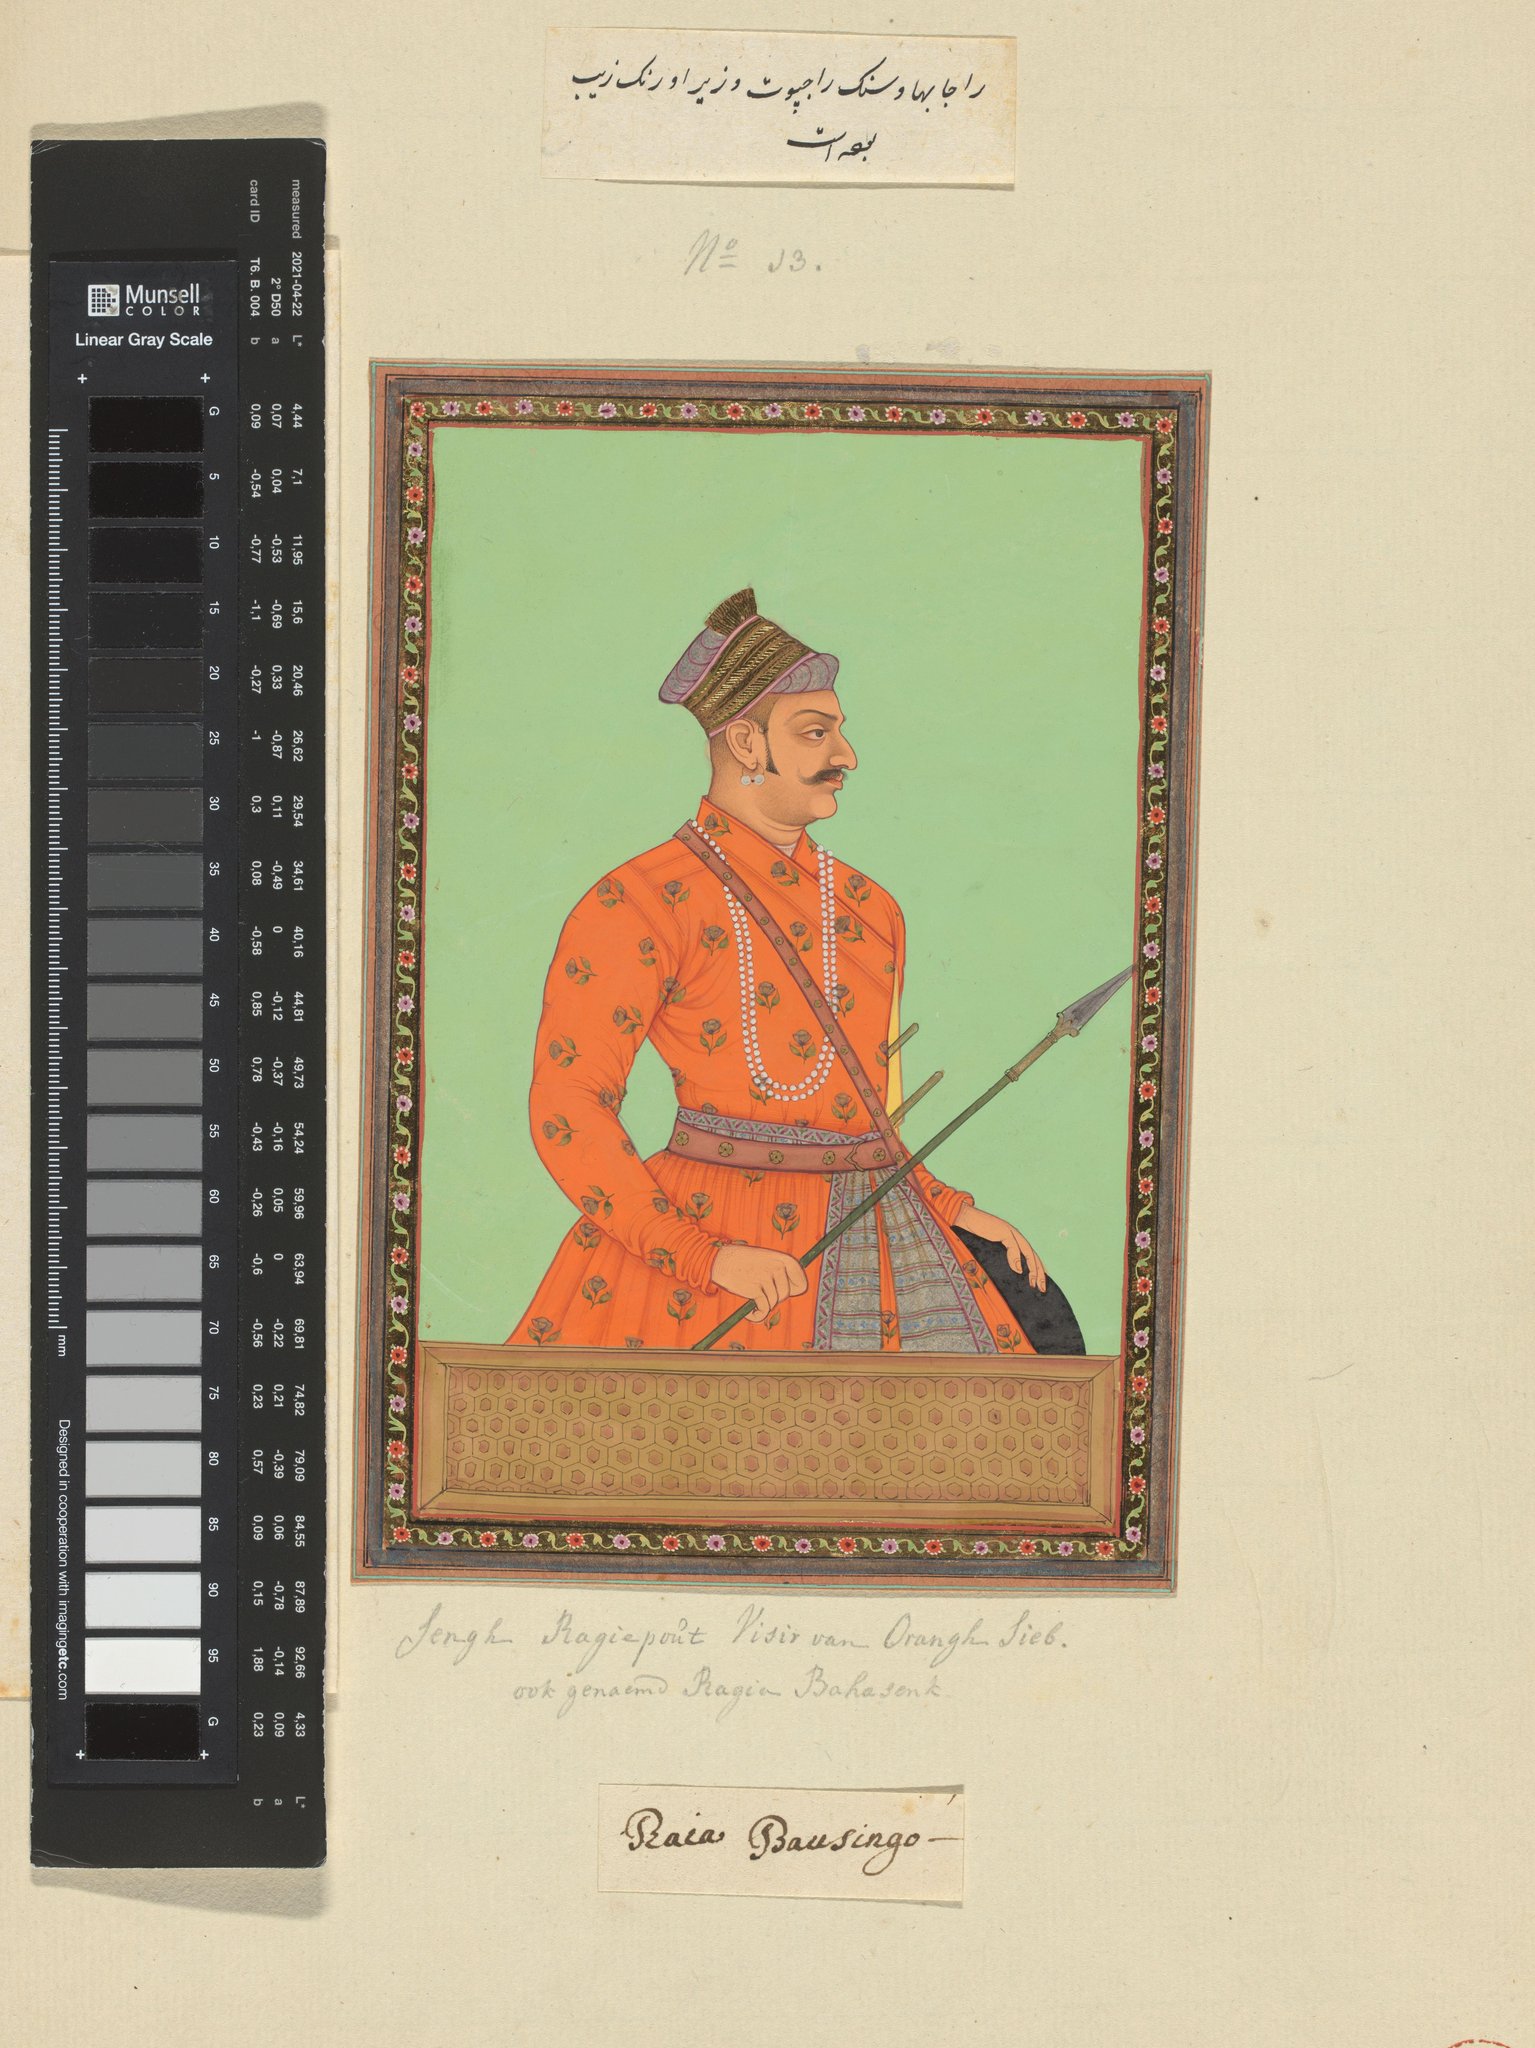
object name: drawing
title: Portret van Raja Bhao Sing Rajput, die vizier van Aurangzeb is geweest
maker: Anonymous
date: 1686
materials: paint, gold leaf, gouache, paper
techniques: brush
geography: golkonda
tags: print maker, nicolaes cornelisz. witsen, historical person (...) - historical person (...) portrayed alone, ruler, sovereign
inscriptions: annotation: ‘Sengh Ragiepout Visir van Orangh Sieb, ook genaamd Ragia Bahasenk’, collector's mark: Lugt 1838, collector's mark: Lugt 240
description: Raja Bhao Sing Rajput is tot aan zijn heupen afgebeeld, naar rechts gewend, met in zijn rechter hand een speer, zijn linker hand rust op een schild, in zijn gordel een kattan. Blad 13 in het `Witsen-Album', met 49 Indiase miniaturen van vorsten. Boven het portret een stukje papier met de naam in het Perzisch. Onder het portret een stukje papier met de naam in het Portugees.